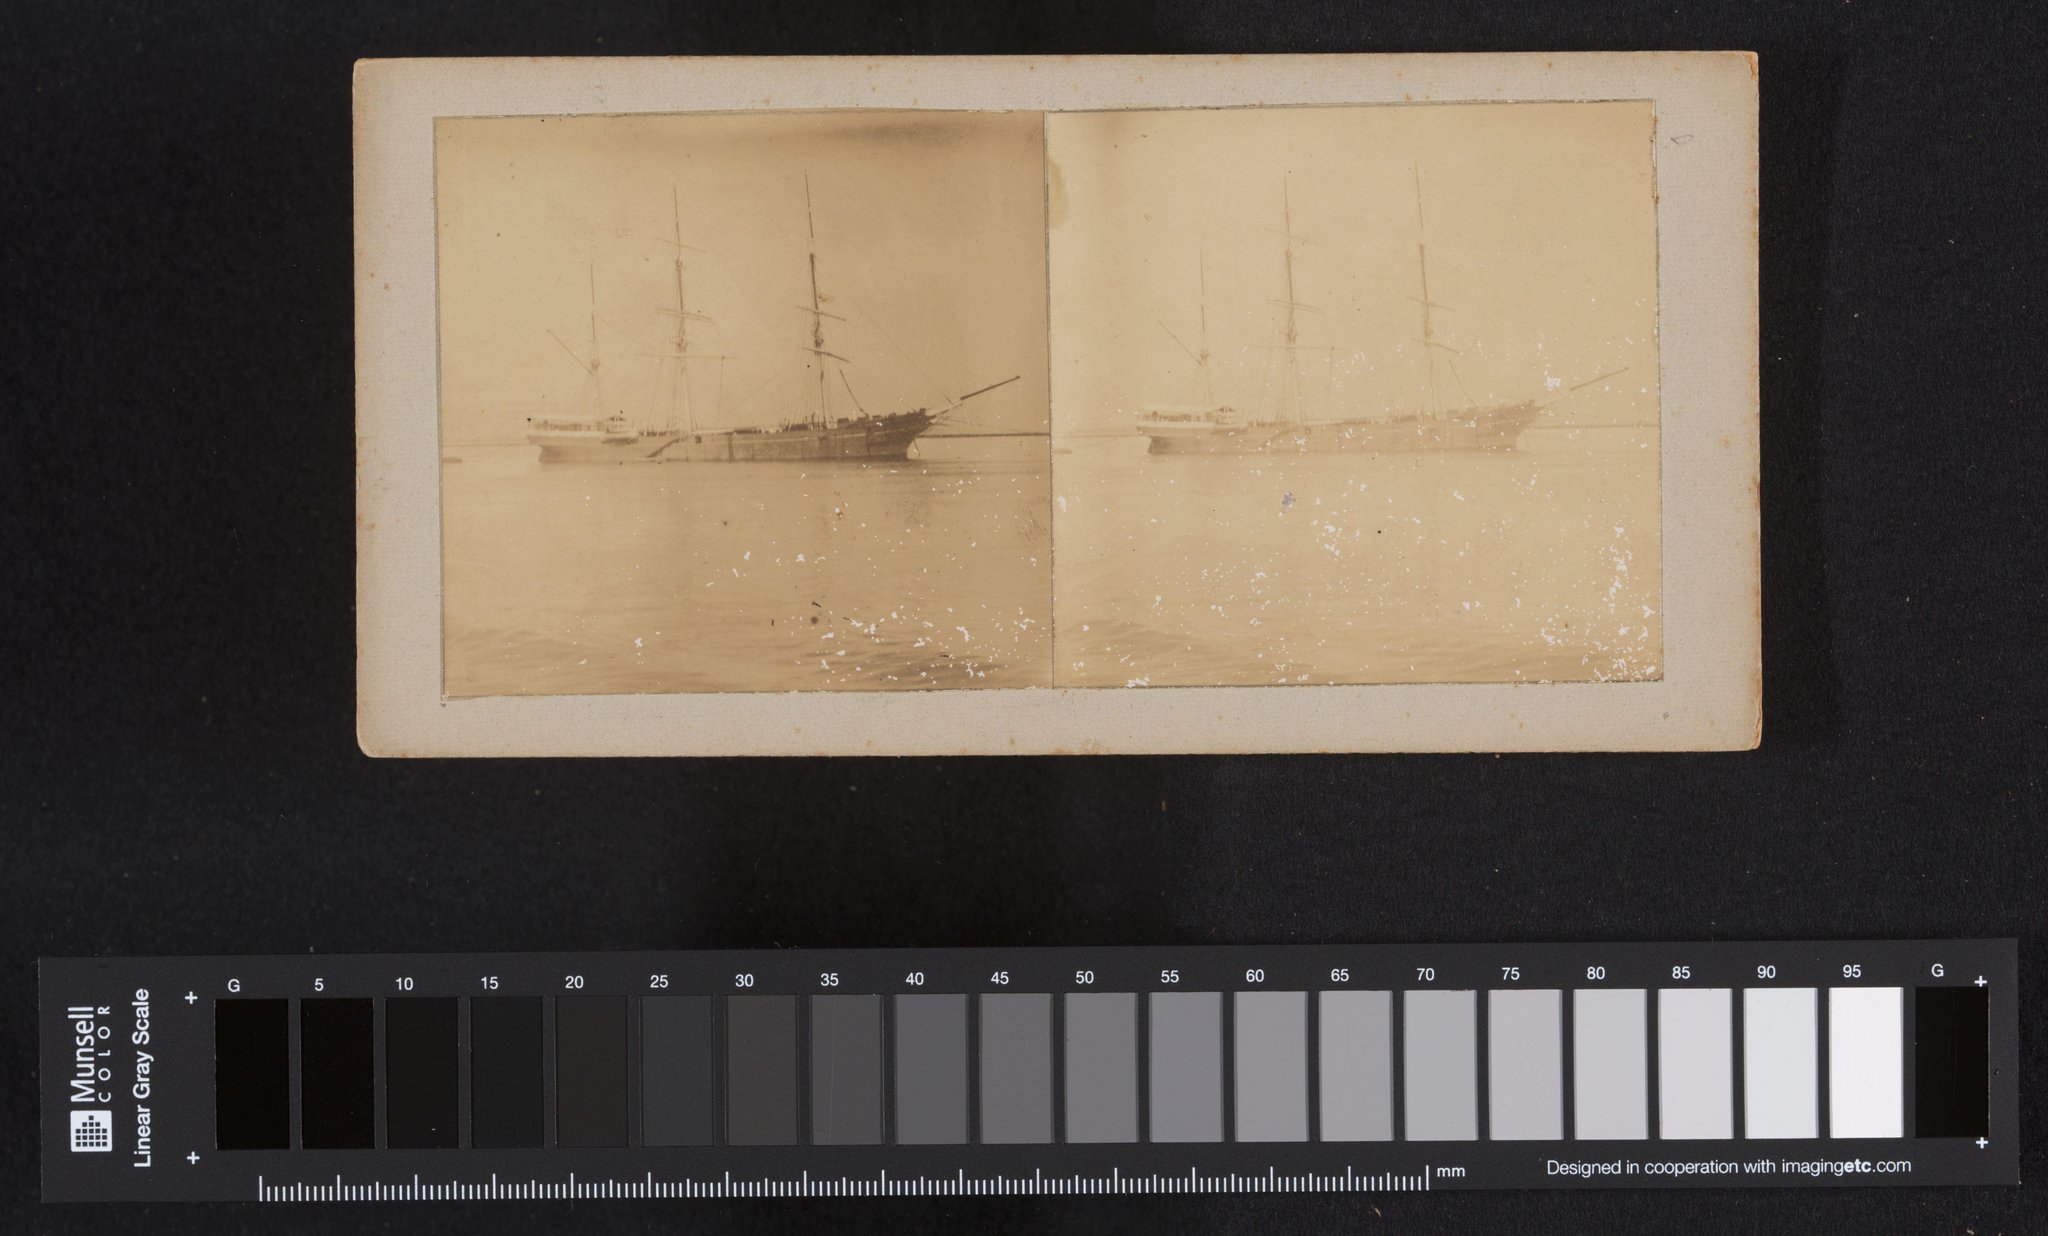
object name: stereograph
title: Het schip de "Nest" te Tandjong Priok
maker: robert julius boers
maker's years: 1867-1932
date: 1900-1922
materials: cardboard, photographic support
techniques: gelatin silver print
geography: tanjung priok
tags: robert julius boers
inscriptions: inscription: ‘de "Nest". Rijstschip in haven Tandjong Priok’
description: Het rijstschip de "Nest" in de haven van Tandjong Priok op Java. Onderdeel van een groep stereofoto's van Robert Julius Boers, chef van het staatsbedrijf de Banka-tinwinning op Banka, uit de periode ca. 1900-1922.